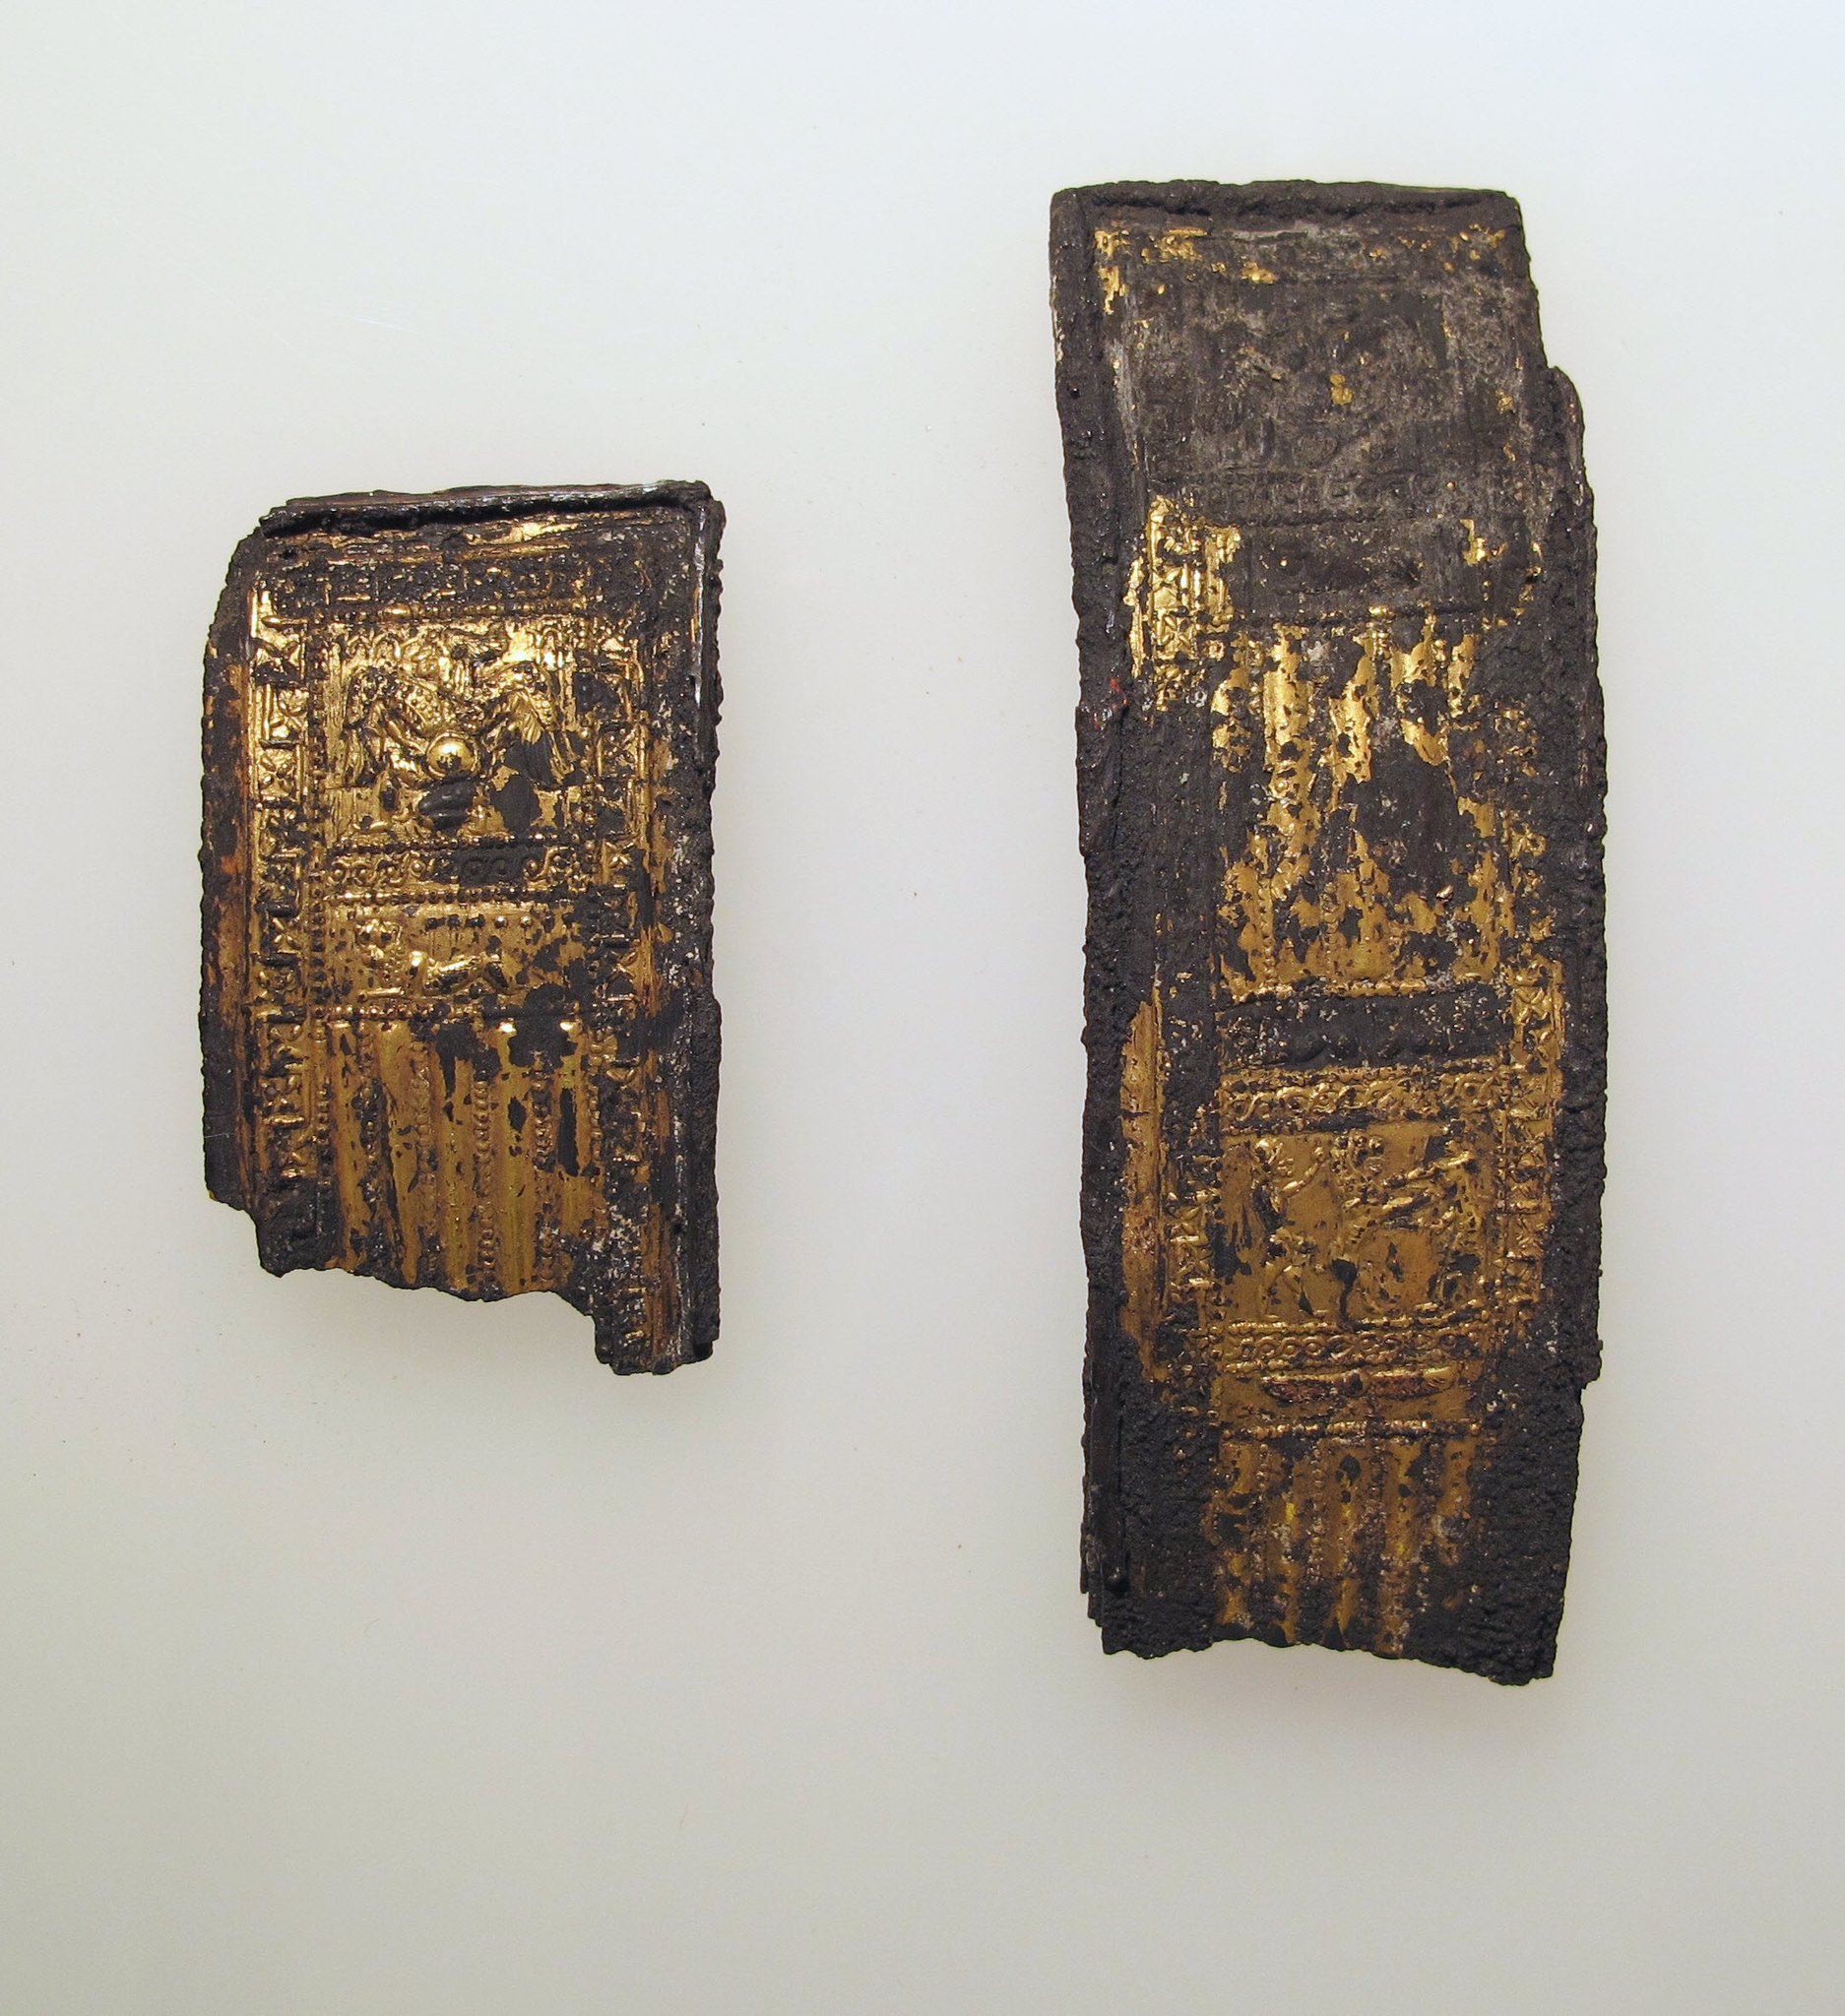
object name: bracelet fragment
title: Two silver bracelet fragments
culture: cypriot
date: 3900 BCE-100 CE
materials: silver